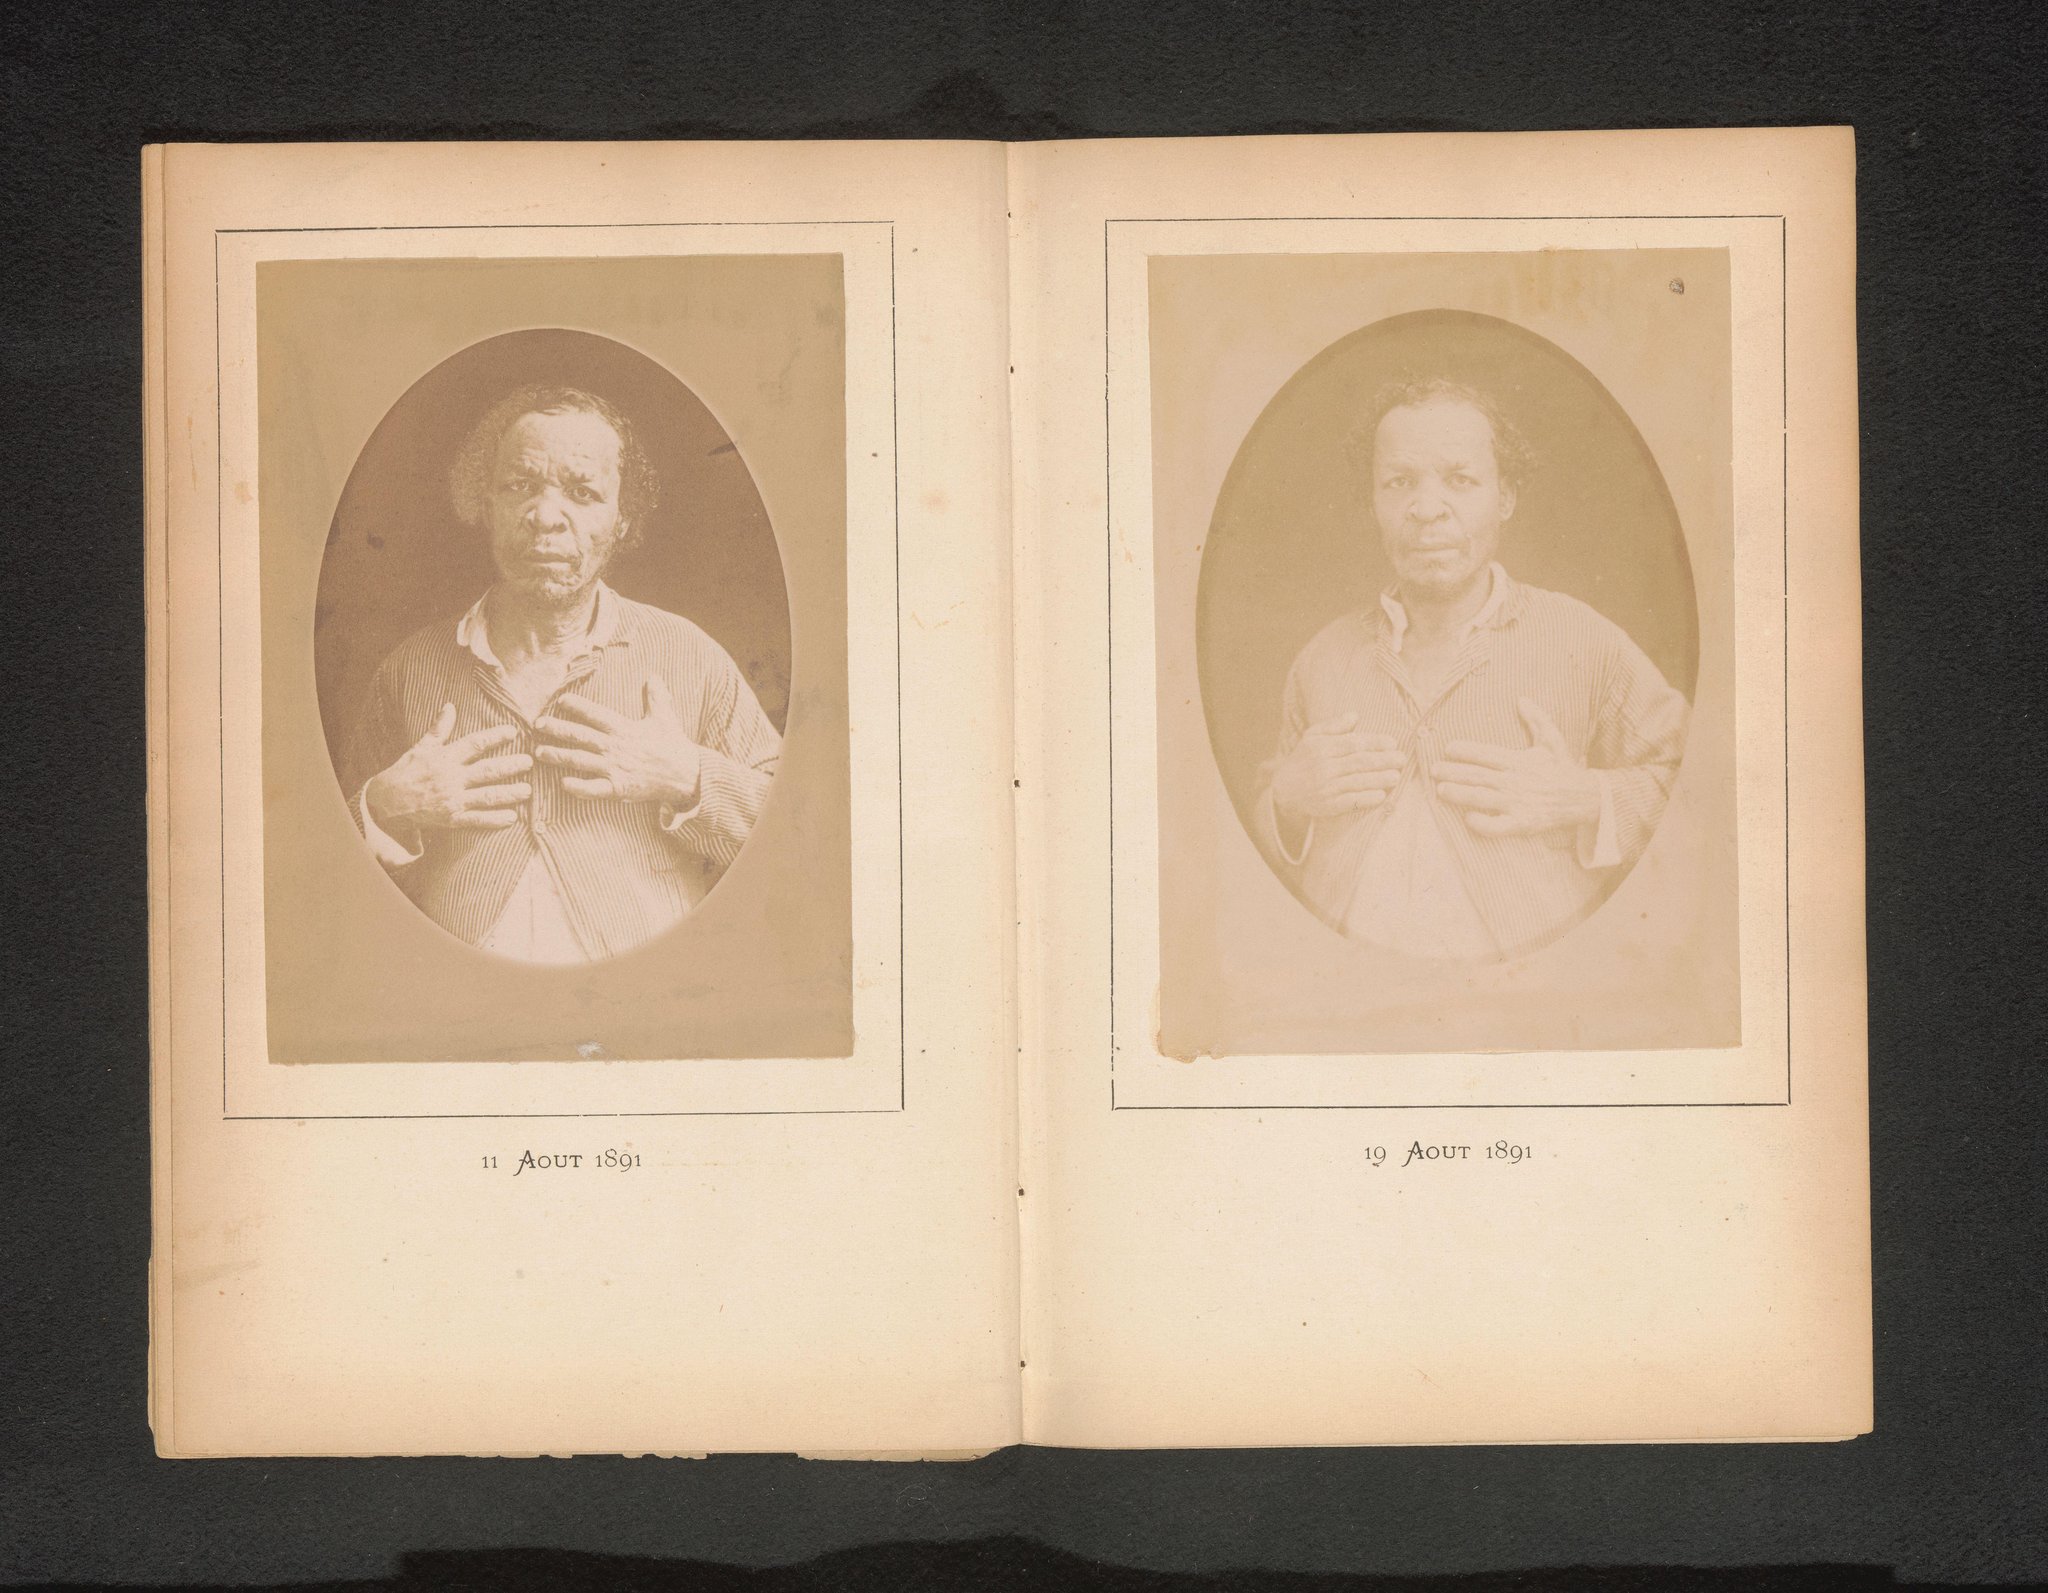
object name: photograph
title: Portret van een man met lepra, na een behandeling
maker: Anonymous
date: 1891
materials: photographic support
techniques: albumen print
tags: leprosy, historical persons not known by name